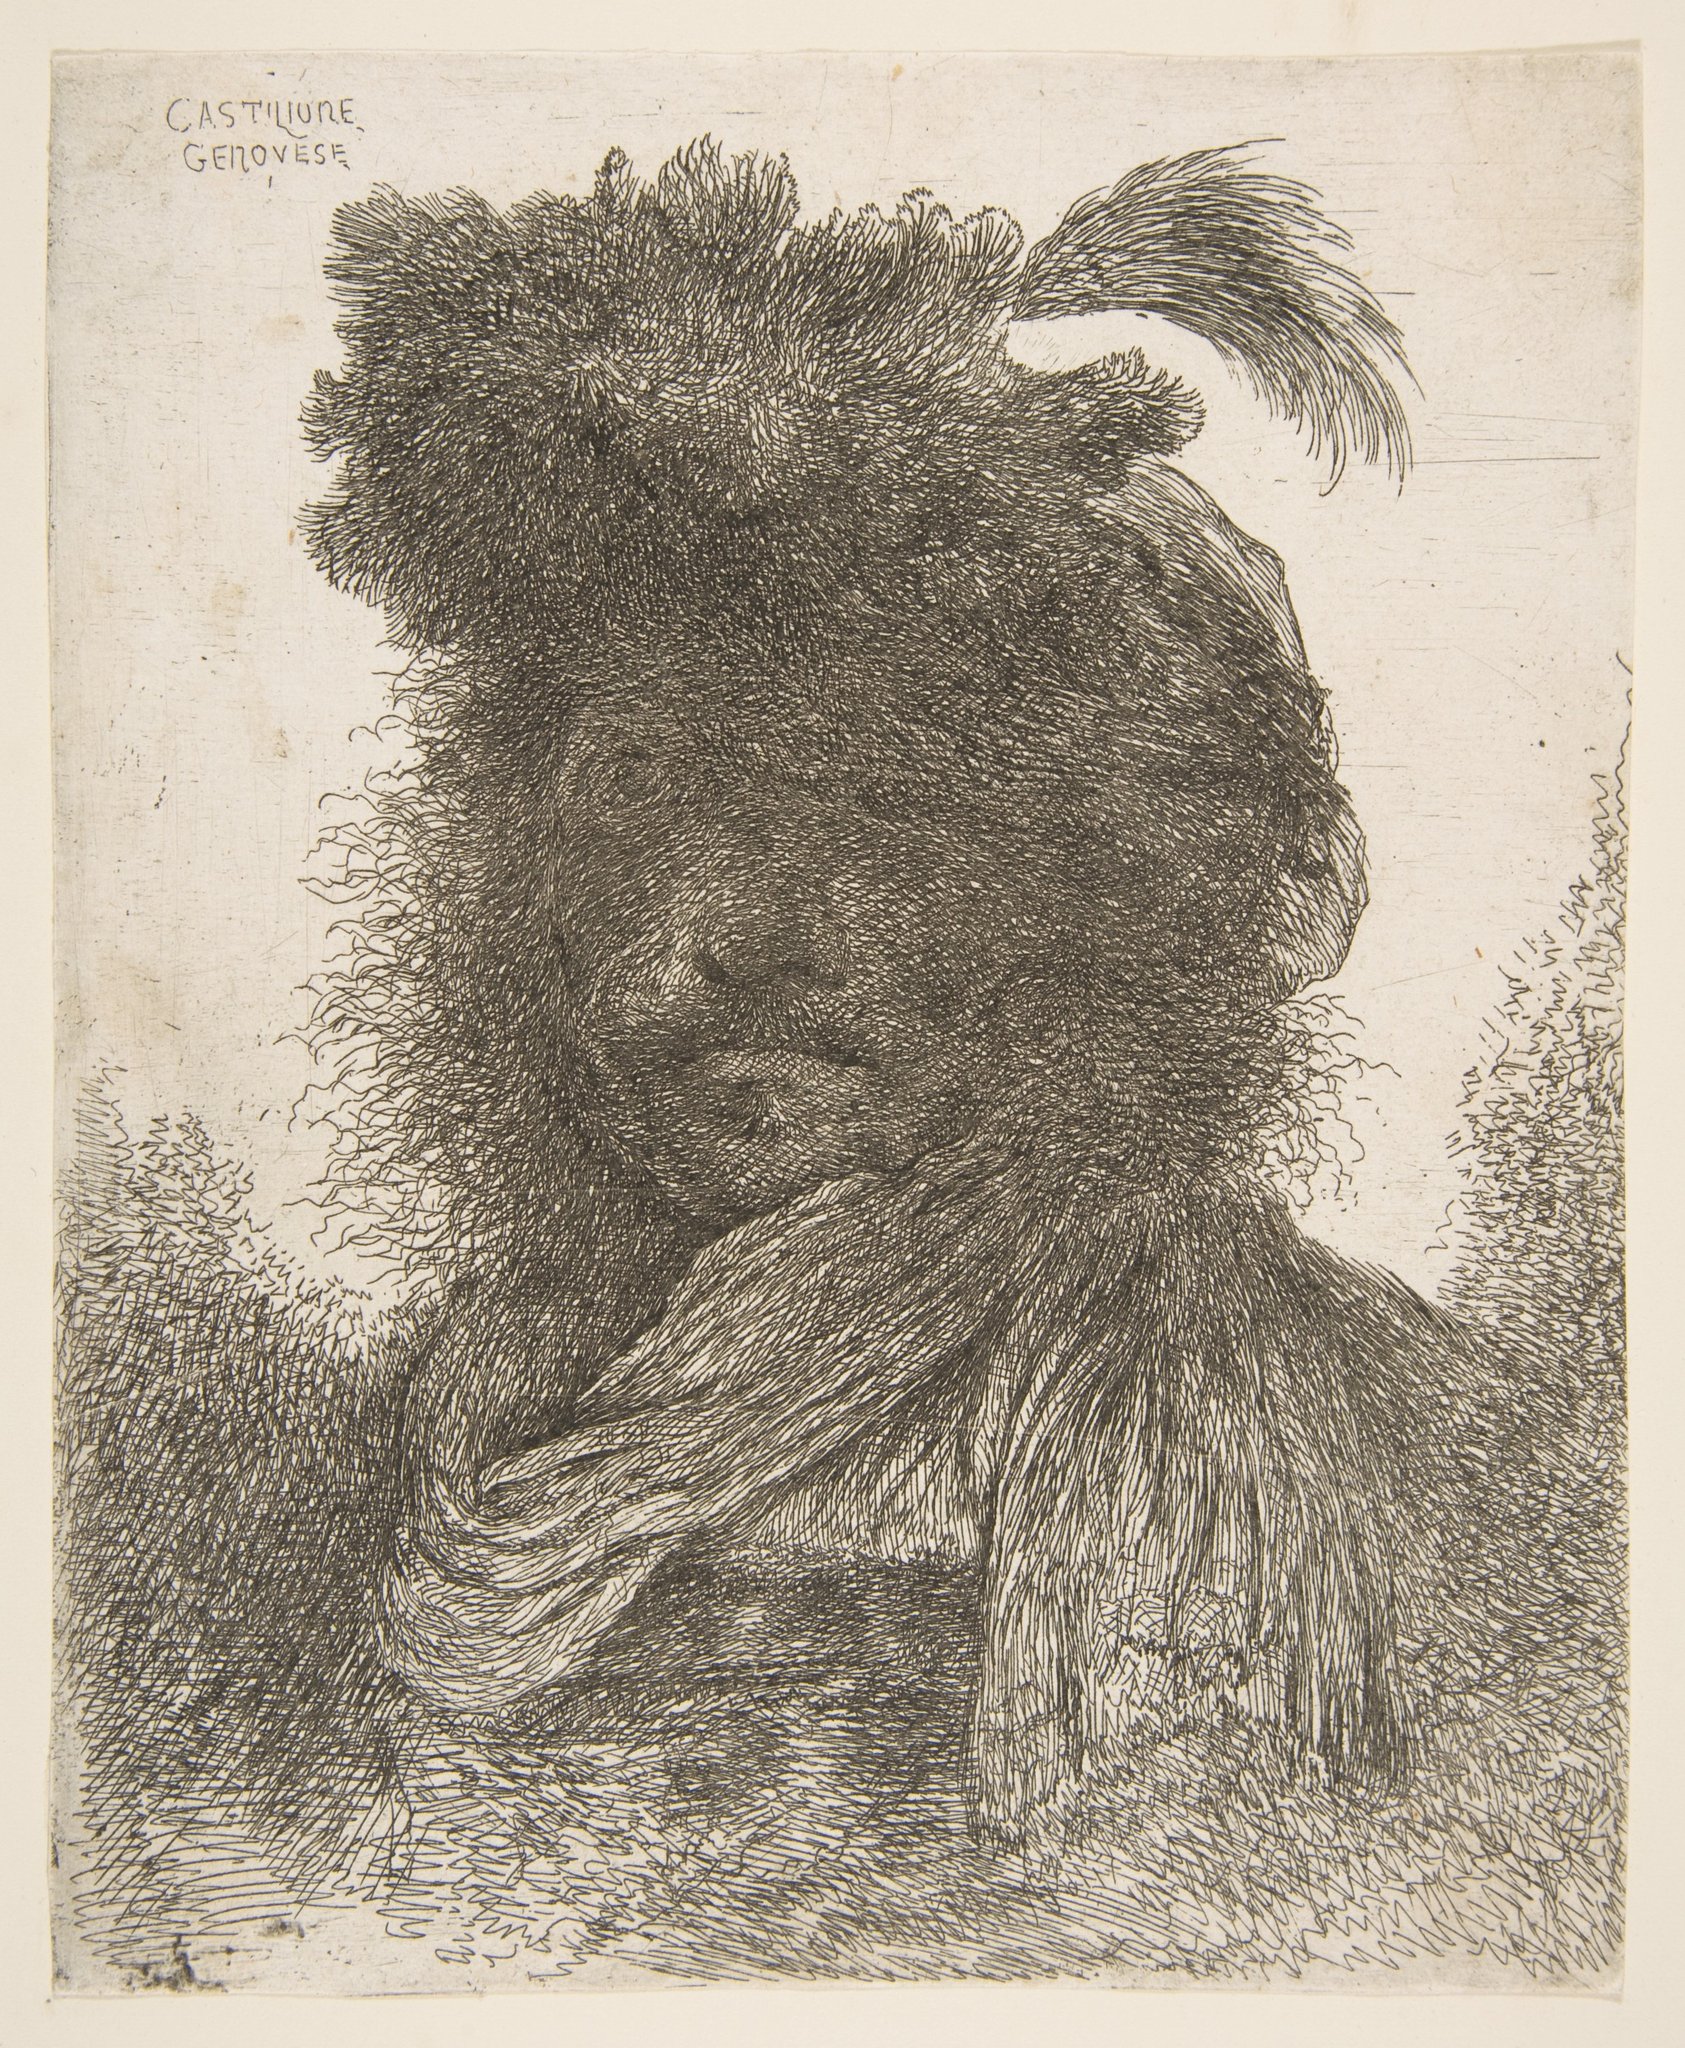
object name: print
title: Head of a man in shadow turned slightly to the left, from "Large Oriental Heads"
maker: giovanni benedetto castiglione (il grechetto)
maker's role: artist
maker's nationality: italian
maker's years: 1609-1664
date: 1645-1650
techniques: etching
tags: heads,men,portraits